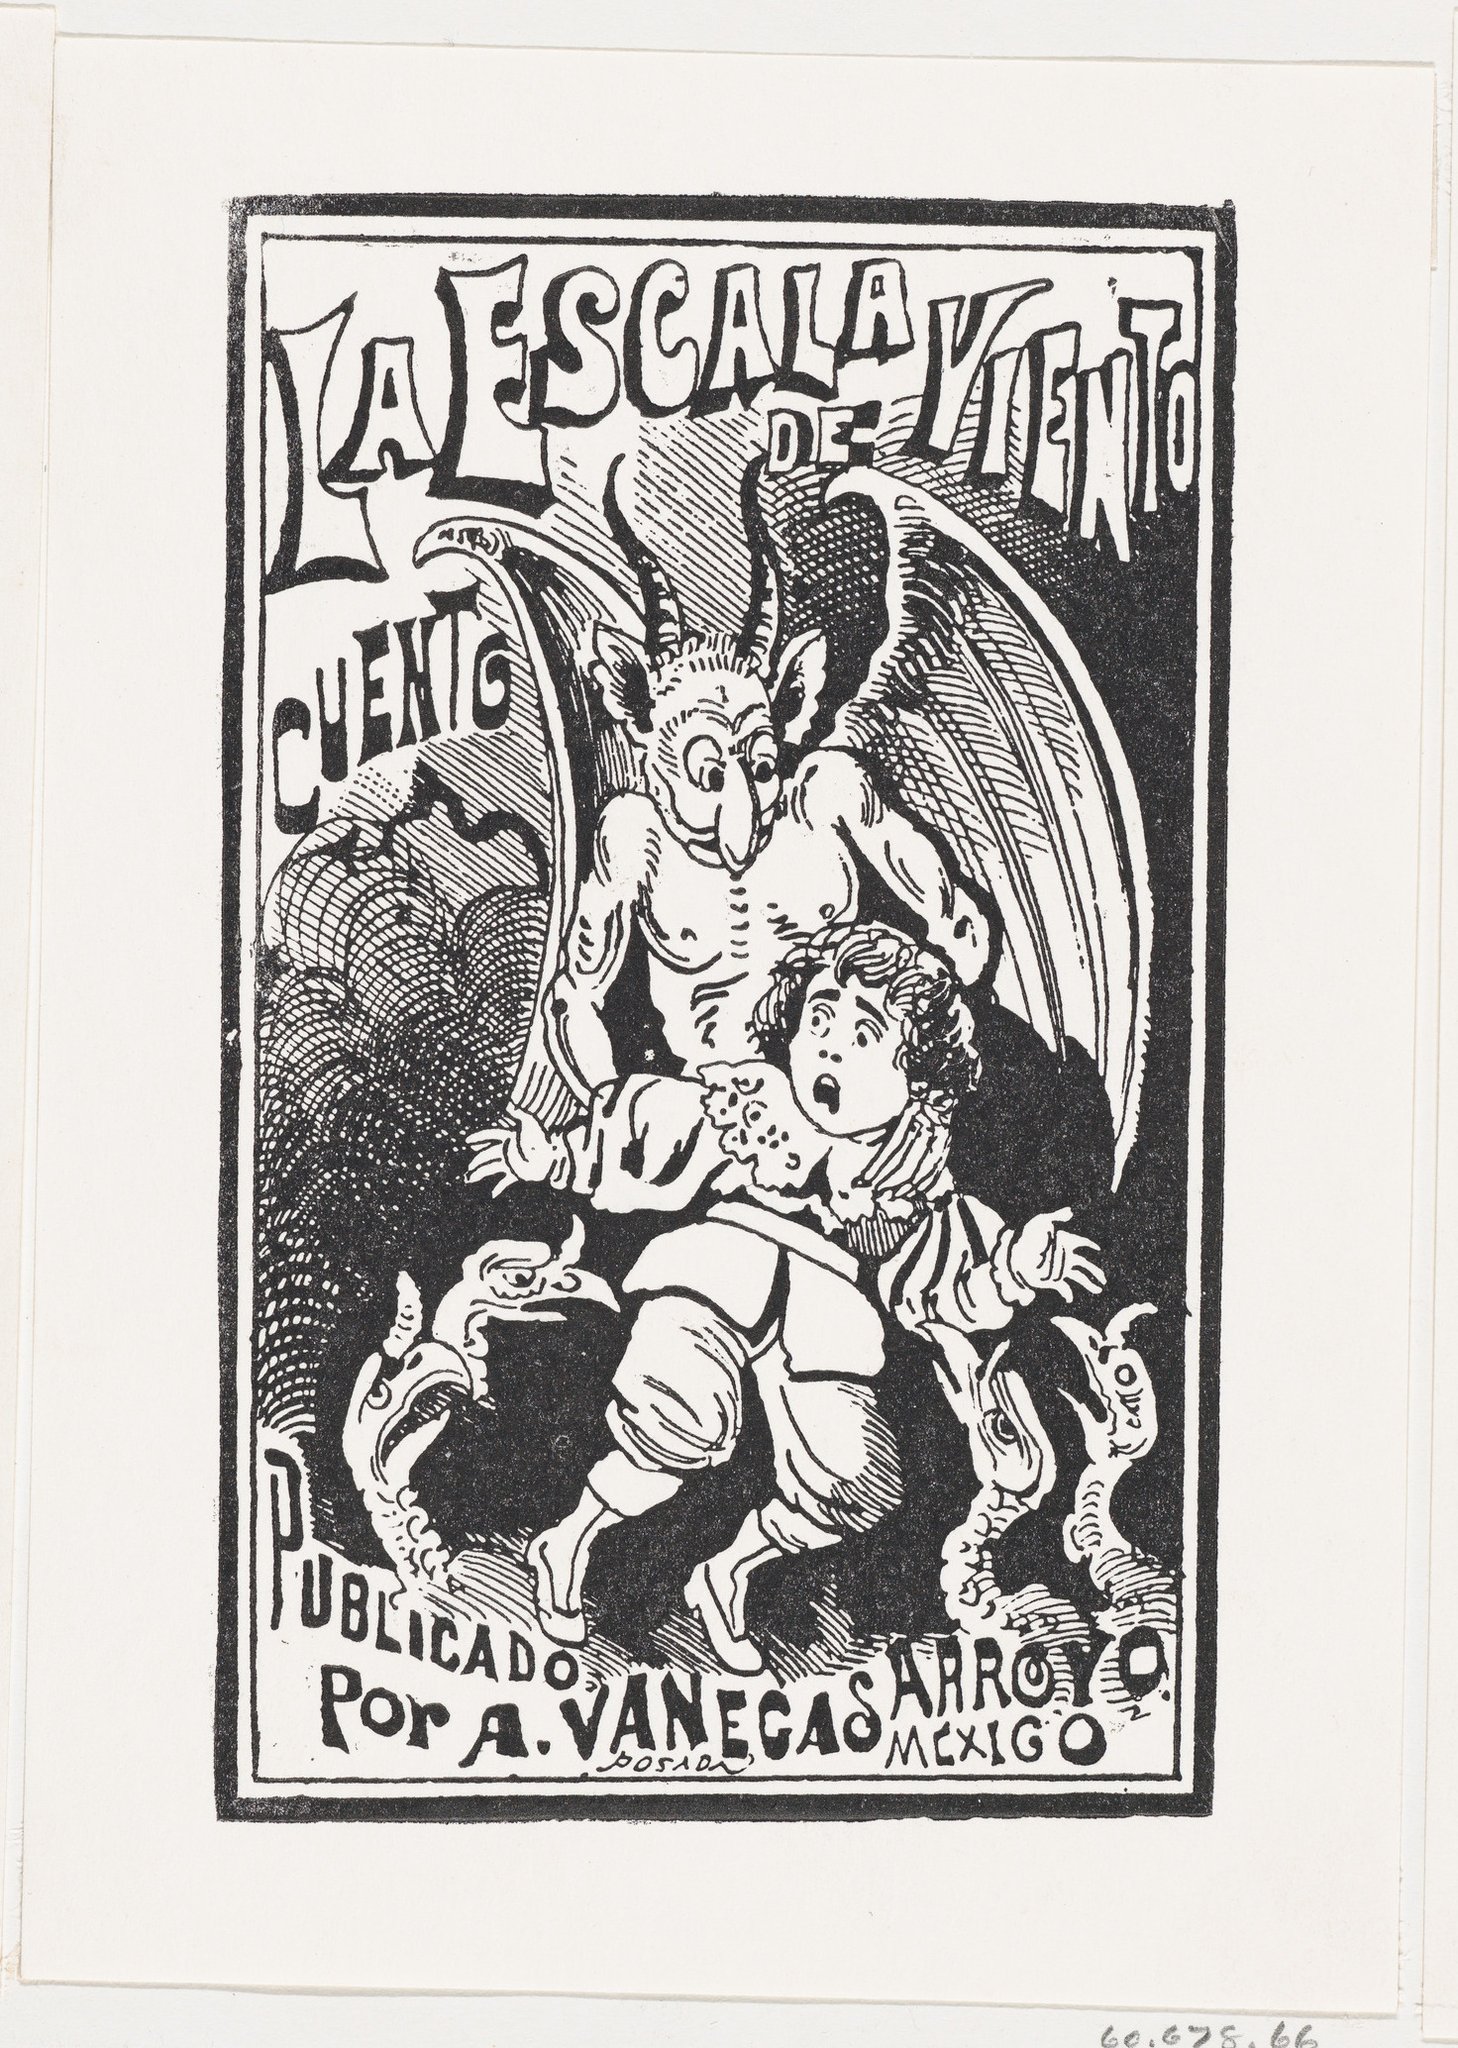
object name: print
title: A demon holding a young boy by his shoulders over a group of vultures, illustration for 'La Escala de Viento'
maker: josé guadalupe posada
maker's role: artist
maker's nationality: mexican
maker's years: 1852-1913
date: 1880-1910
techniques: lithography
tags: fear,boys,demons